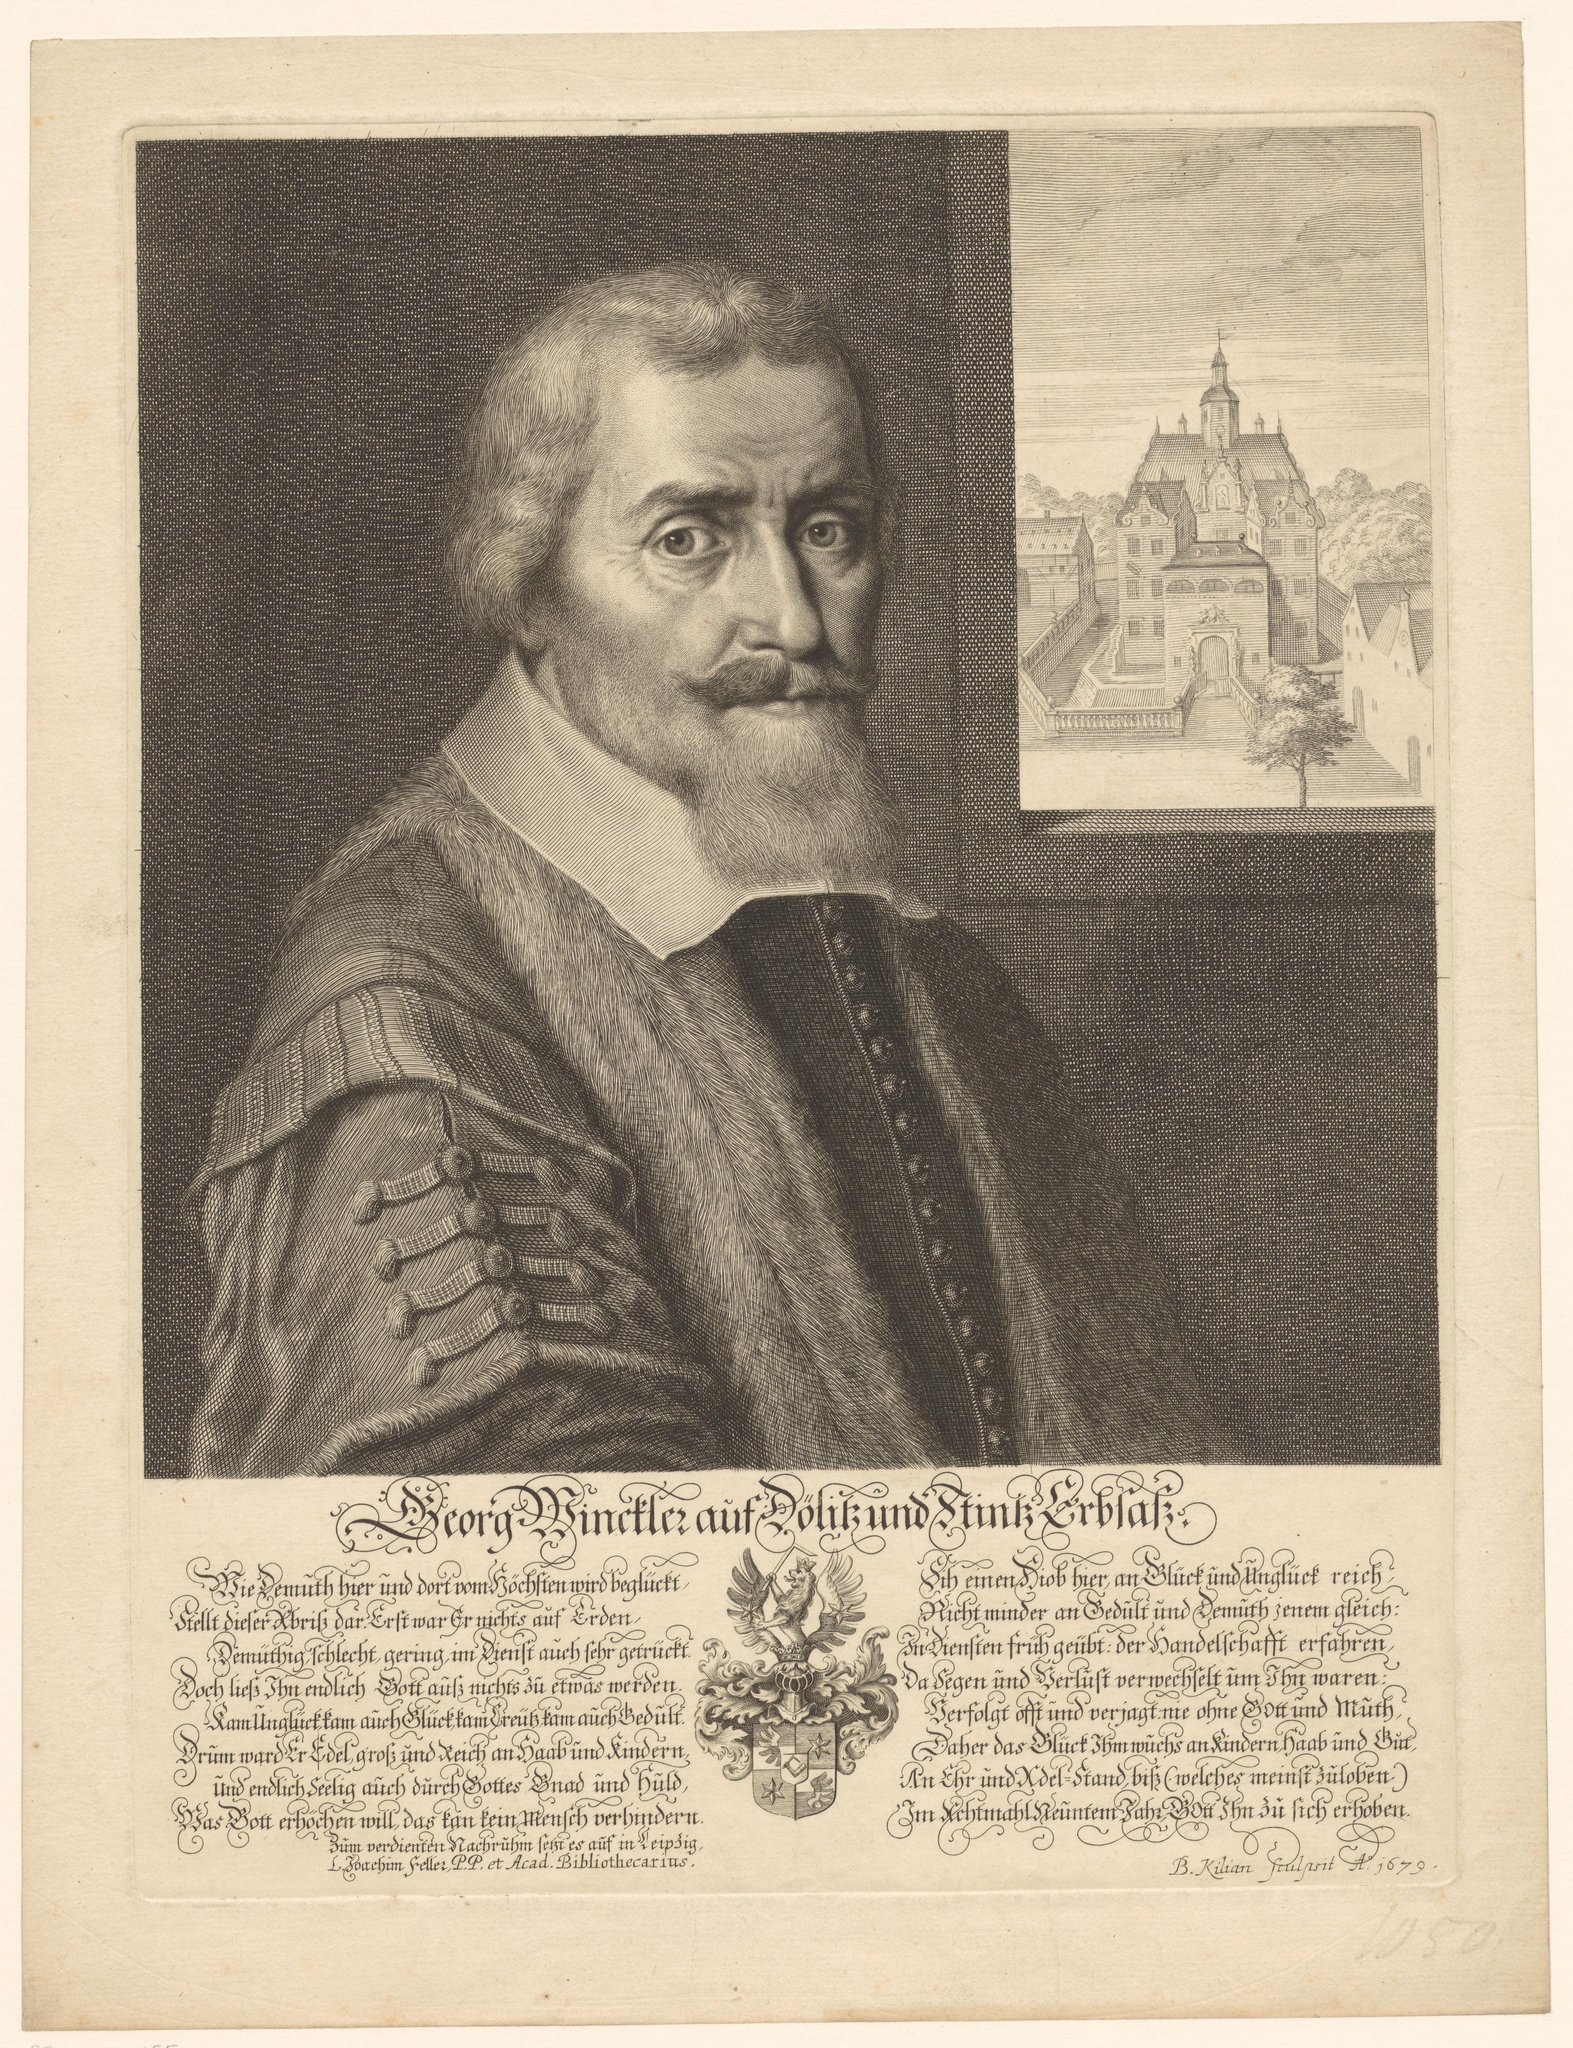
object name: print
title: Portret van Georg Winckler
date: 1679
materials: paper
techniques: engraving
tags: mayor, city council, mayor, burgomaster, historical persons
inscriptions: collector's mark: Lugt 2228